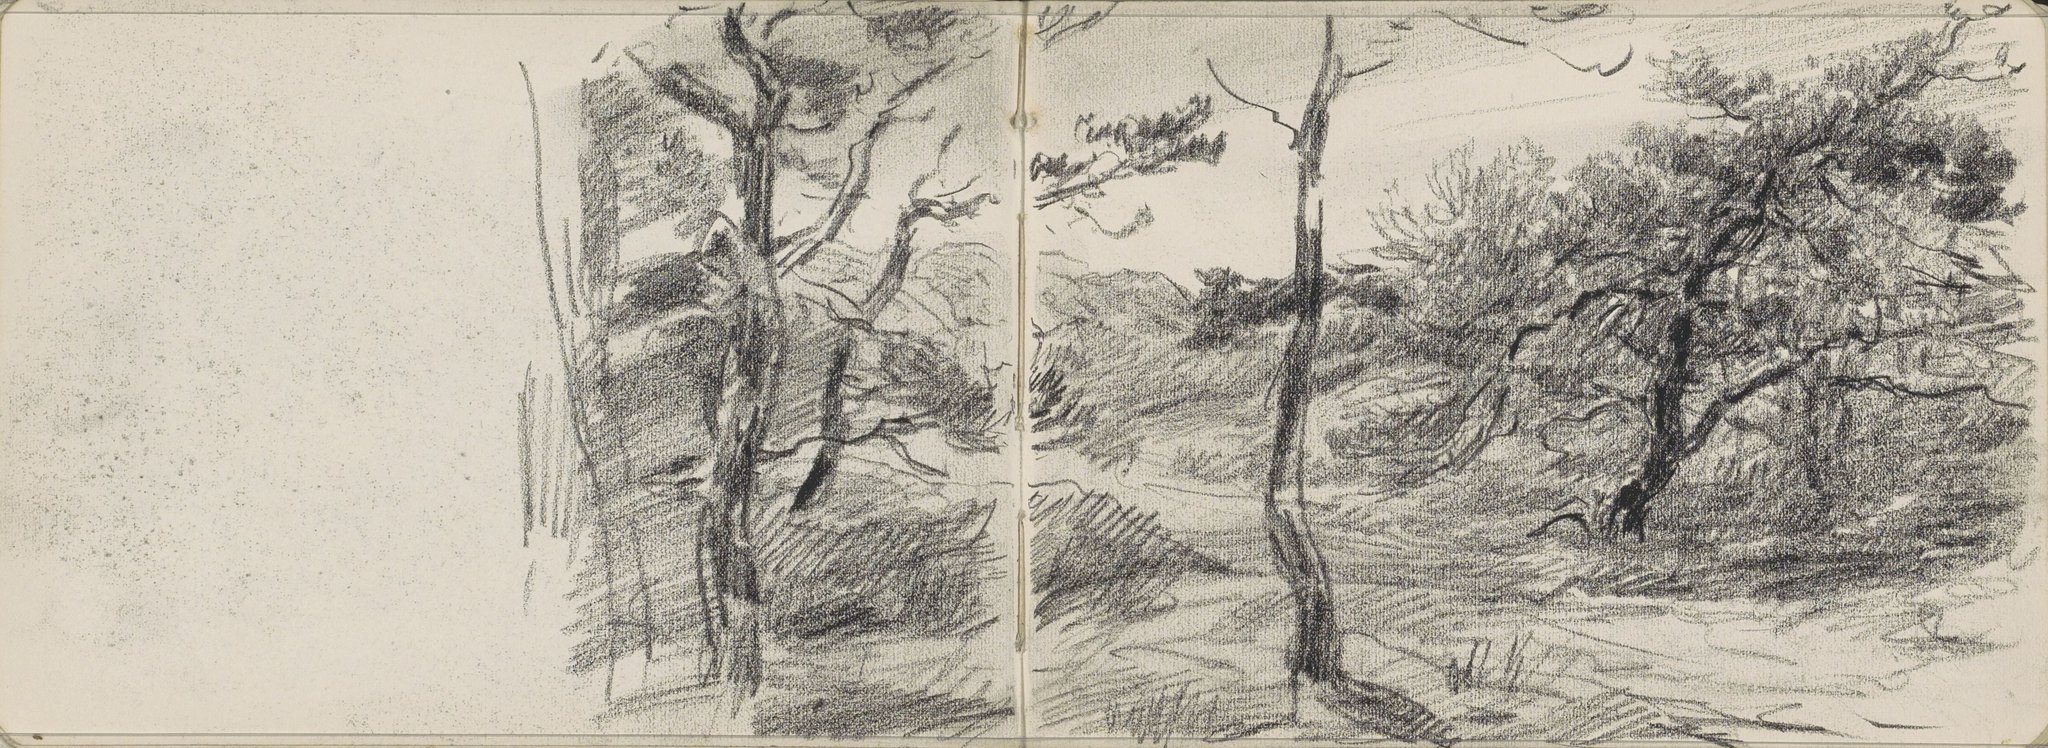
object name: sketchbook leaf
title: Duinlandschap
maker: johan antonie de jonge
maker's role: draughtsman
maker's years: 1864-1927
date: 1881-1927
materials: chalk, paper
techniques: stumping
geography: south holland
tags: dunes (sea not visible); in the dunes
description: Duinlandschap. Blad 8 verso en blad 9 recto uit een schetsboek met 28 bladen.